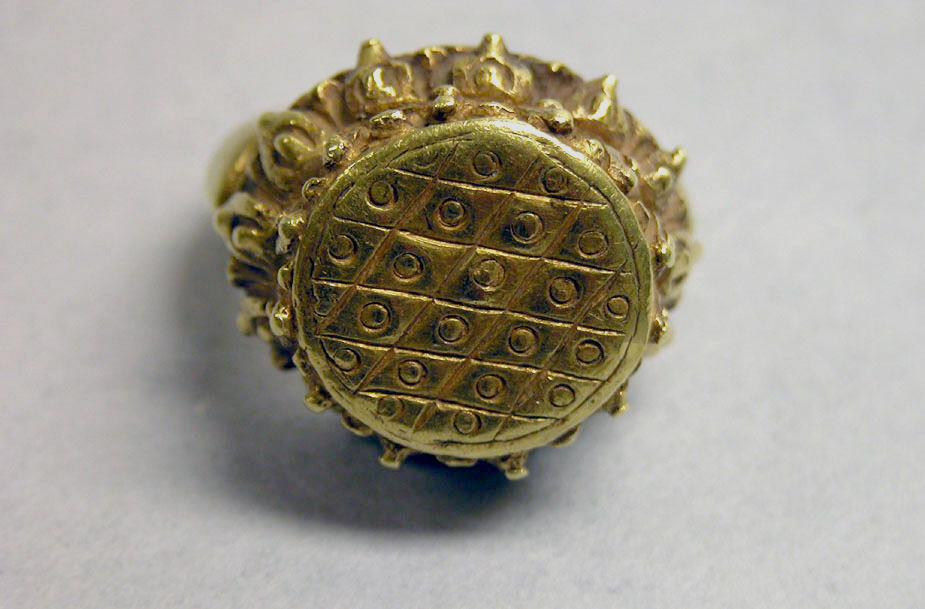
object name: ring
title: Stirrup-shaped Ring with Oval Bezel with Diaper Design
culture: indonesian, javanese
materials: gold